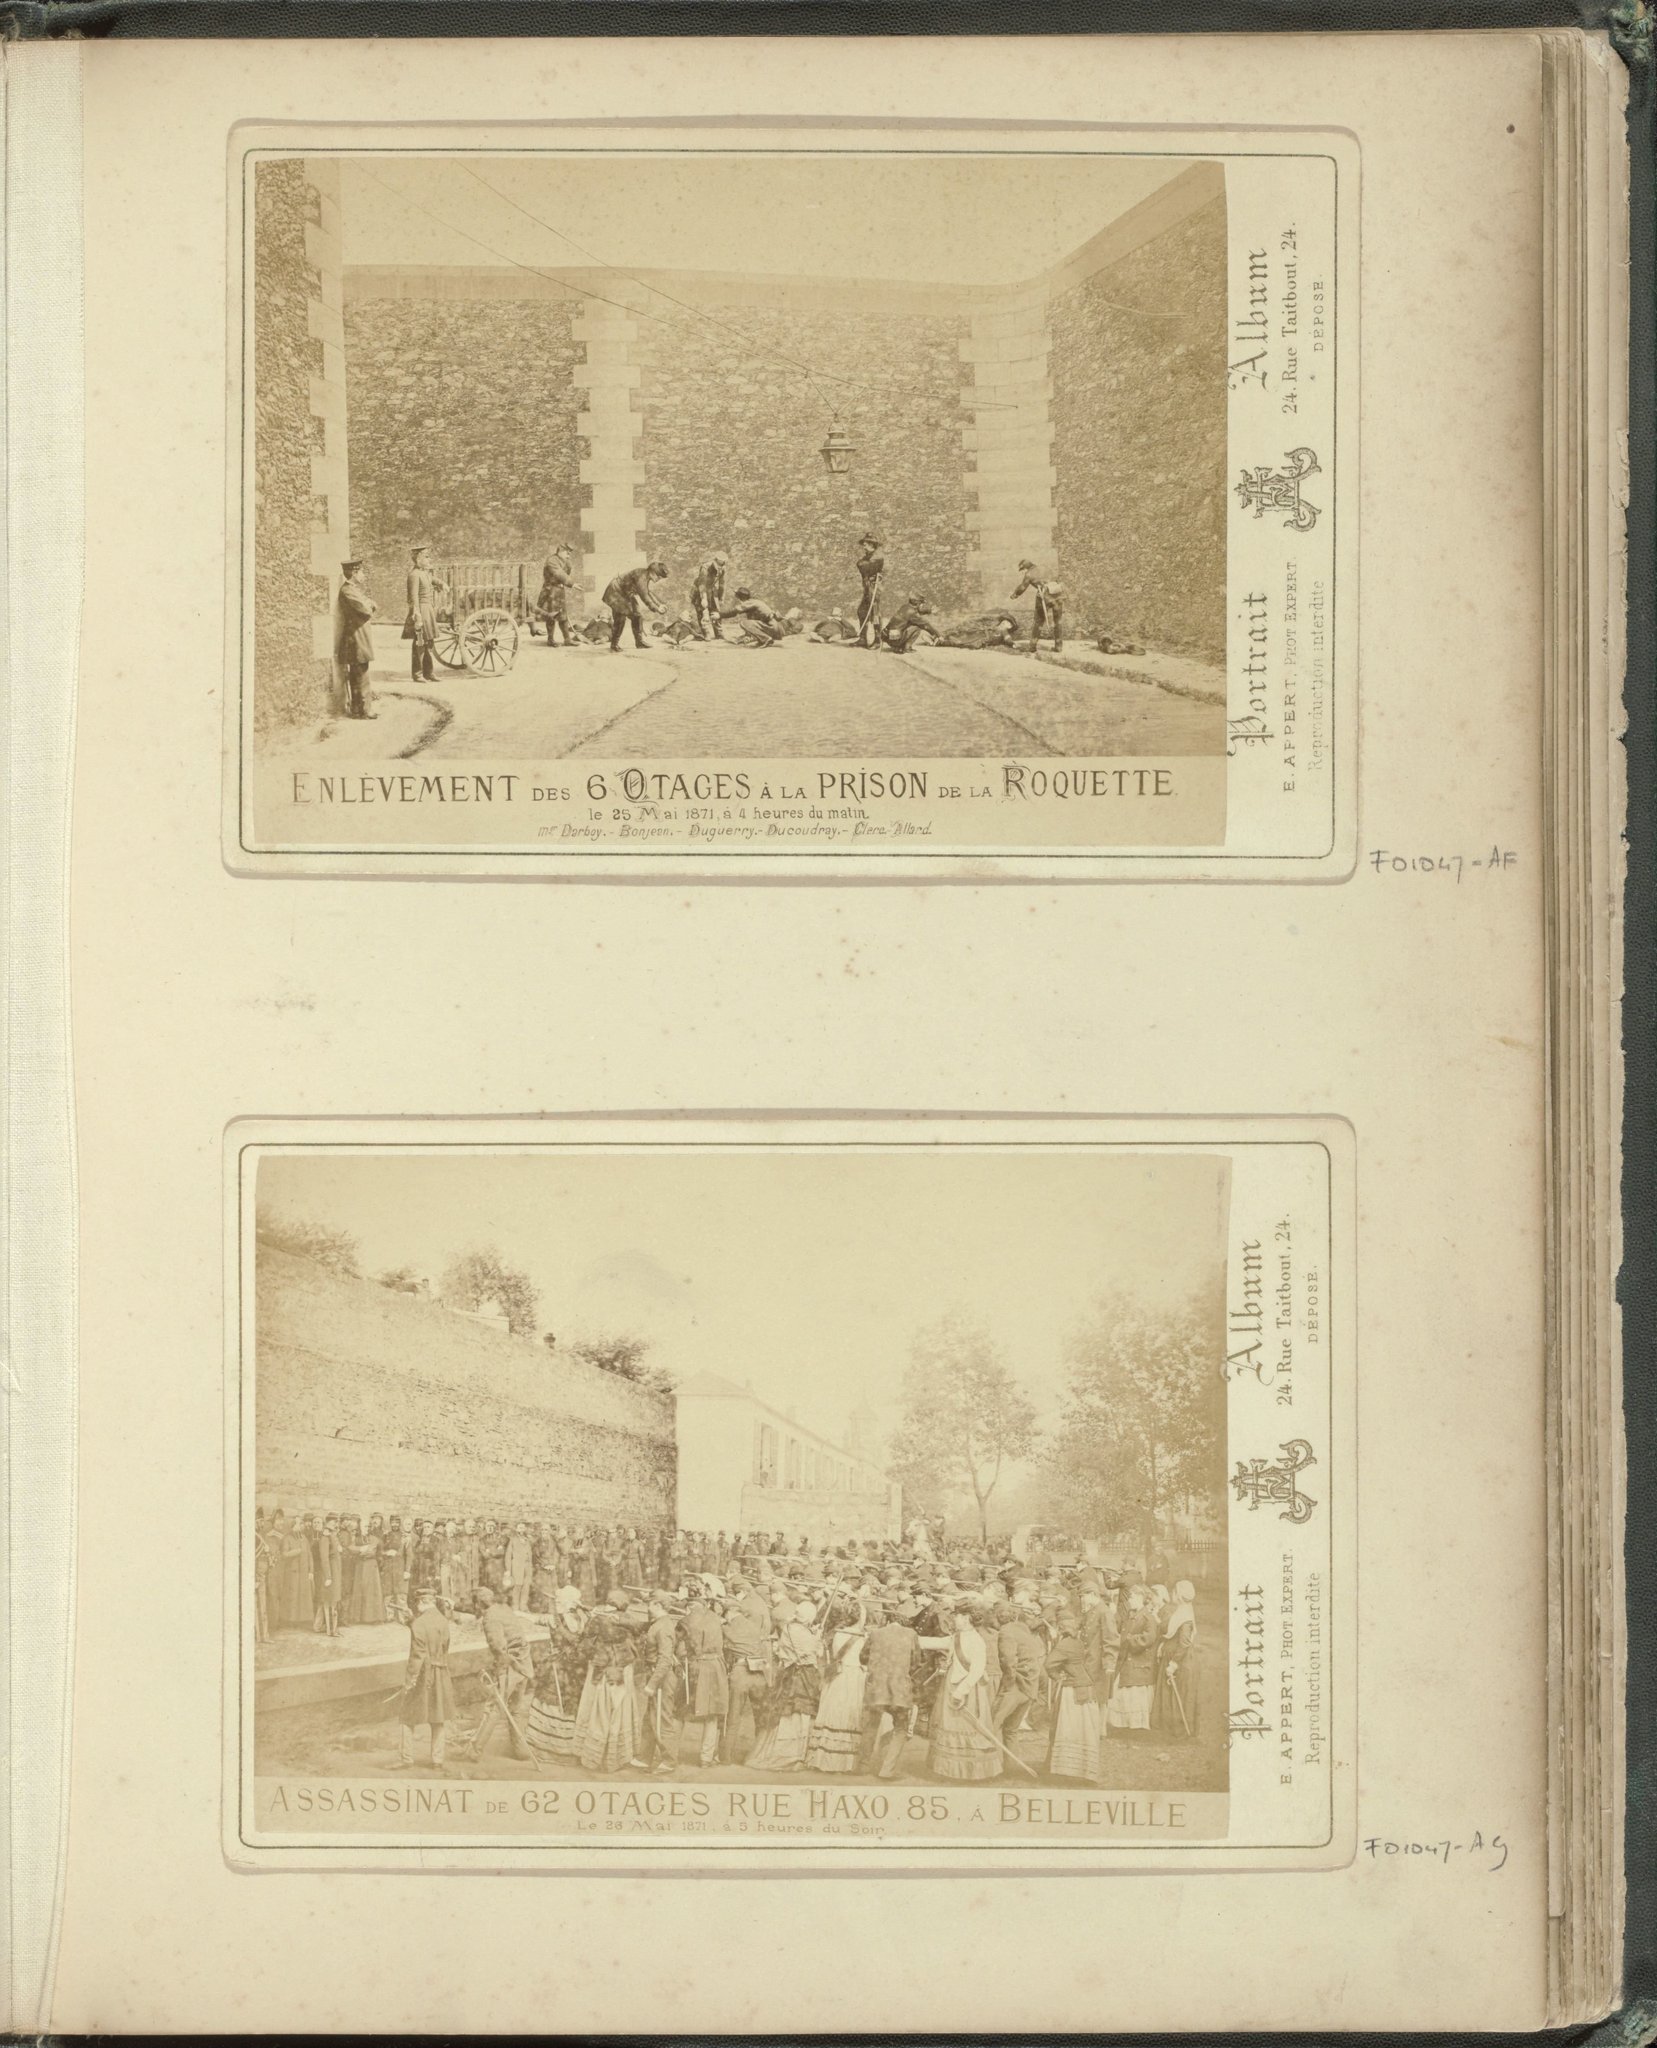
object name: album leaf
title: Fotomontage van de verwijdering van de lijken van zes geëxecuteerde gijzelaars in de Parijse gevangenis la Roquette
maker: ernest eugène appert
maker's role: fotograaf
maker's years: 1830-1891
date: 1871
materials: cardboard, paper, photographic support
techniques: albumen print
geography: paris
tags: prison, jail, death penalty, execution, paris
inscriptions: address: ‘24, Rue Taitbout, 24’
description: Onderdeel van Herdenkingsalbum van rooms-katholieke geestelijken gevallen tijdens de Commune van Parijs.